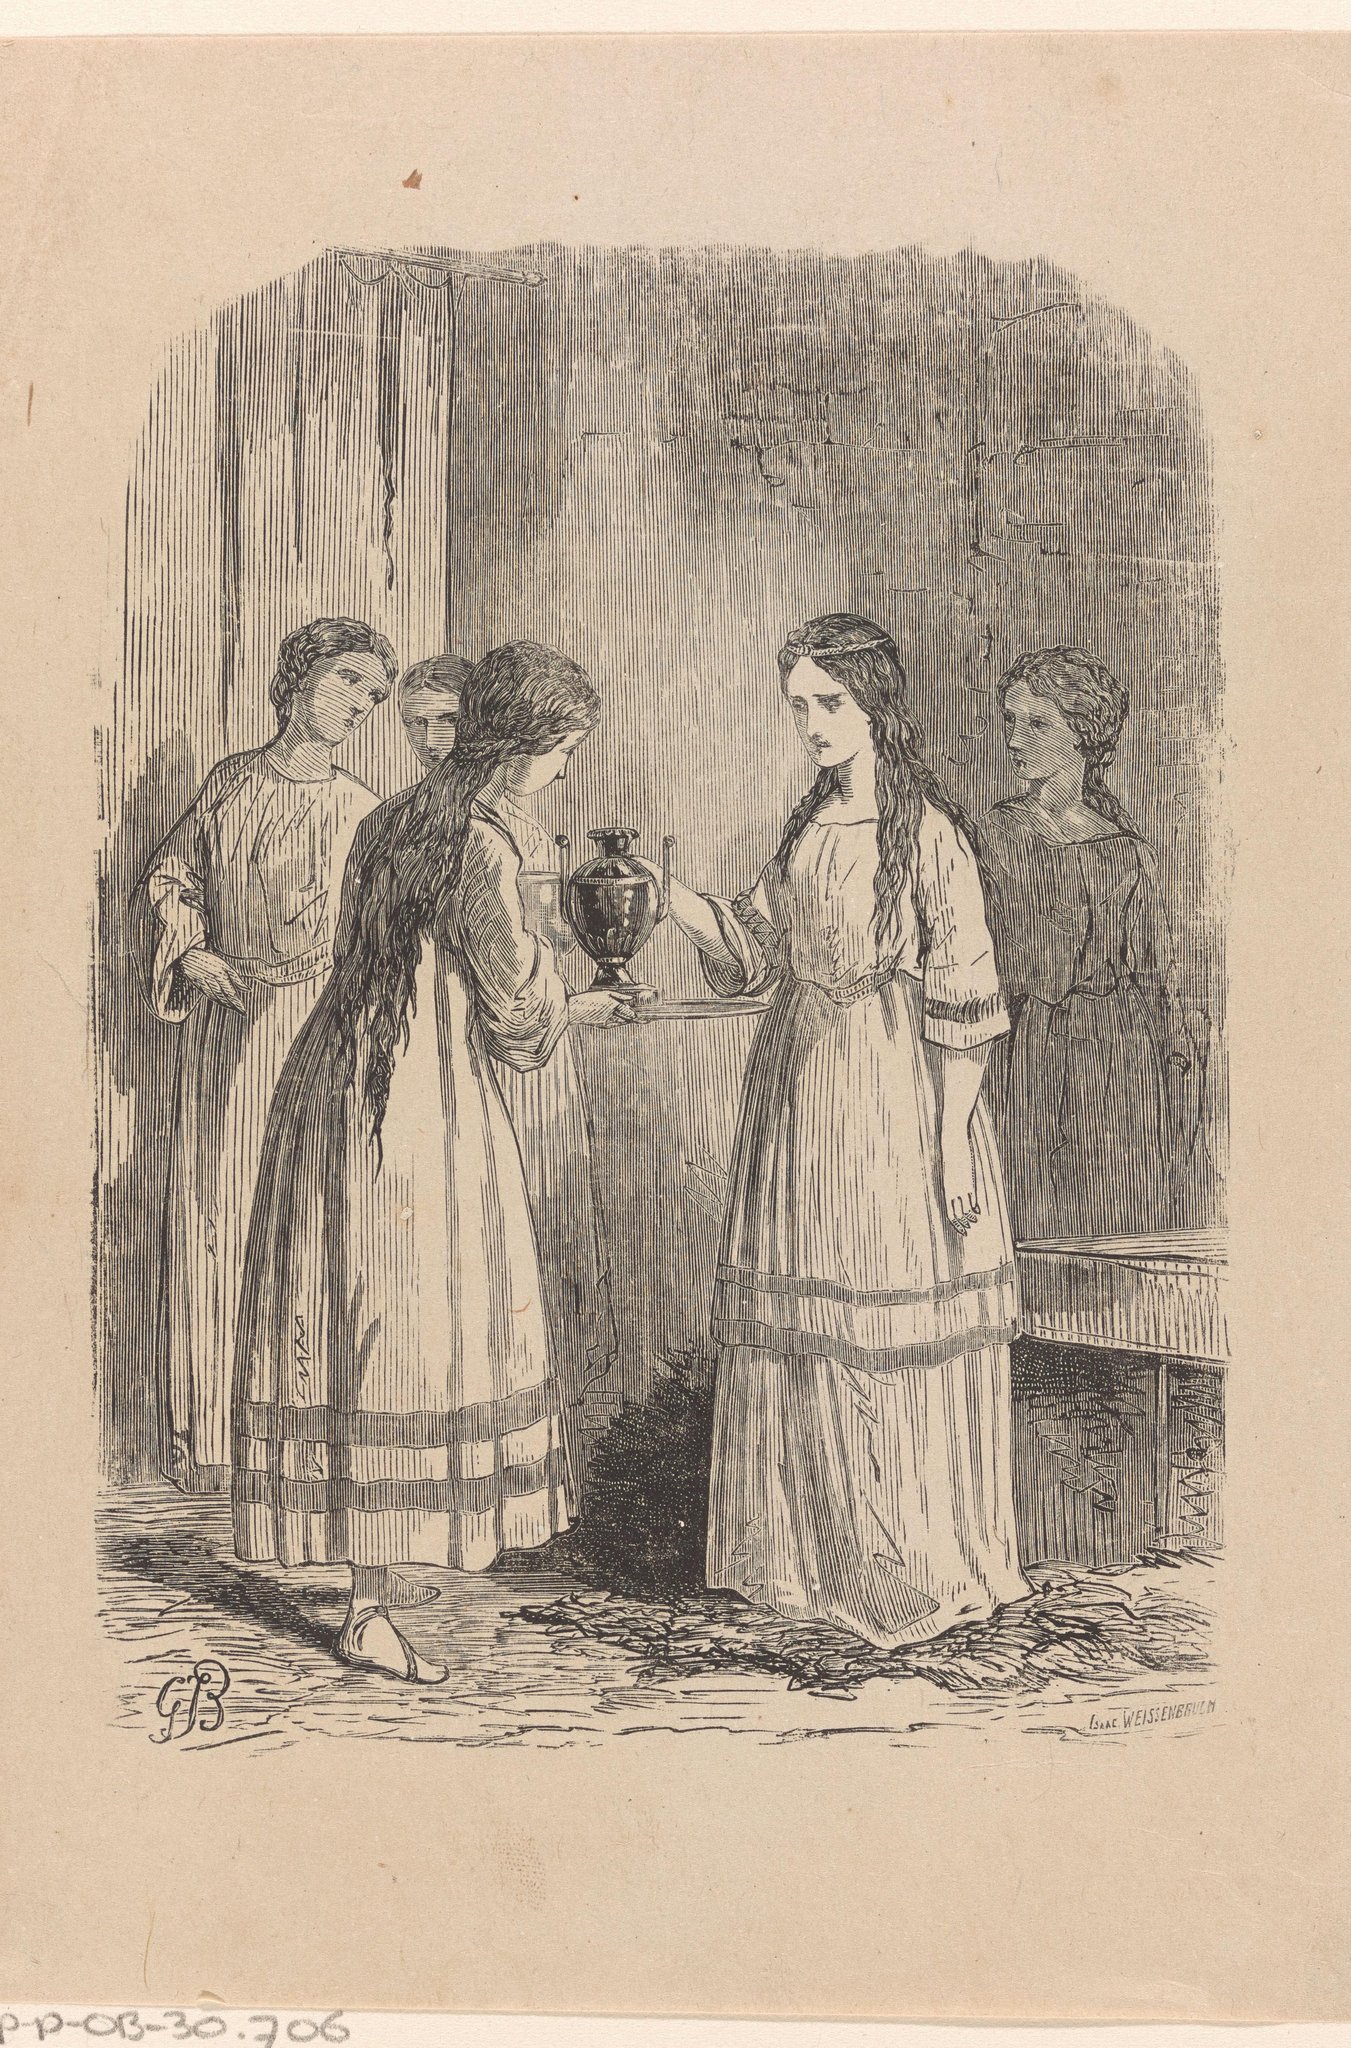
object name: print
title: Vrouw een andere vrouw een kruik aanbiedend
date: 1836-1912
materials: paper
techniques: engraving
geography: netherlands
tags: adult woman (+ five persons), containers